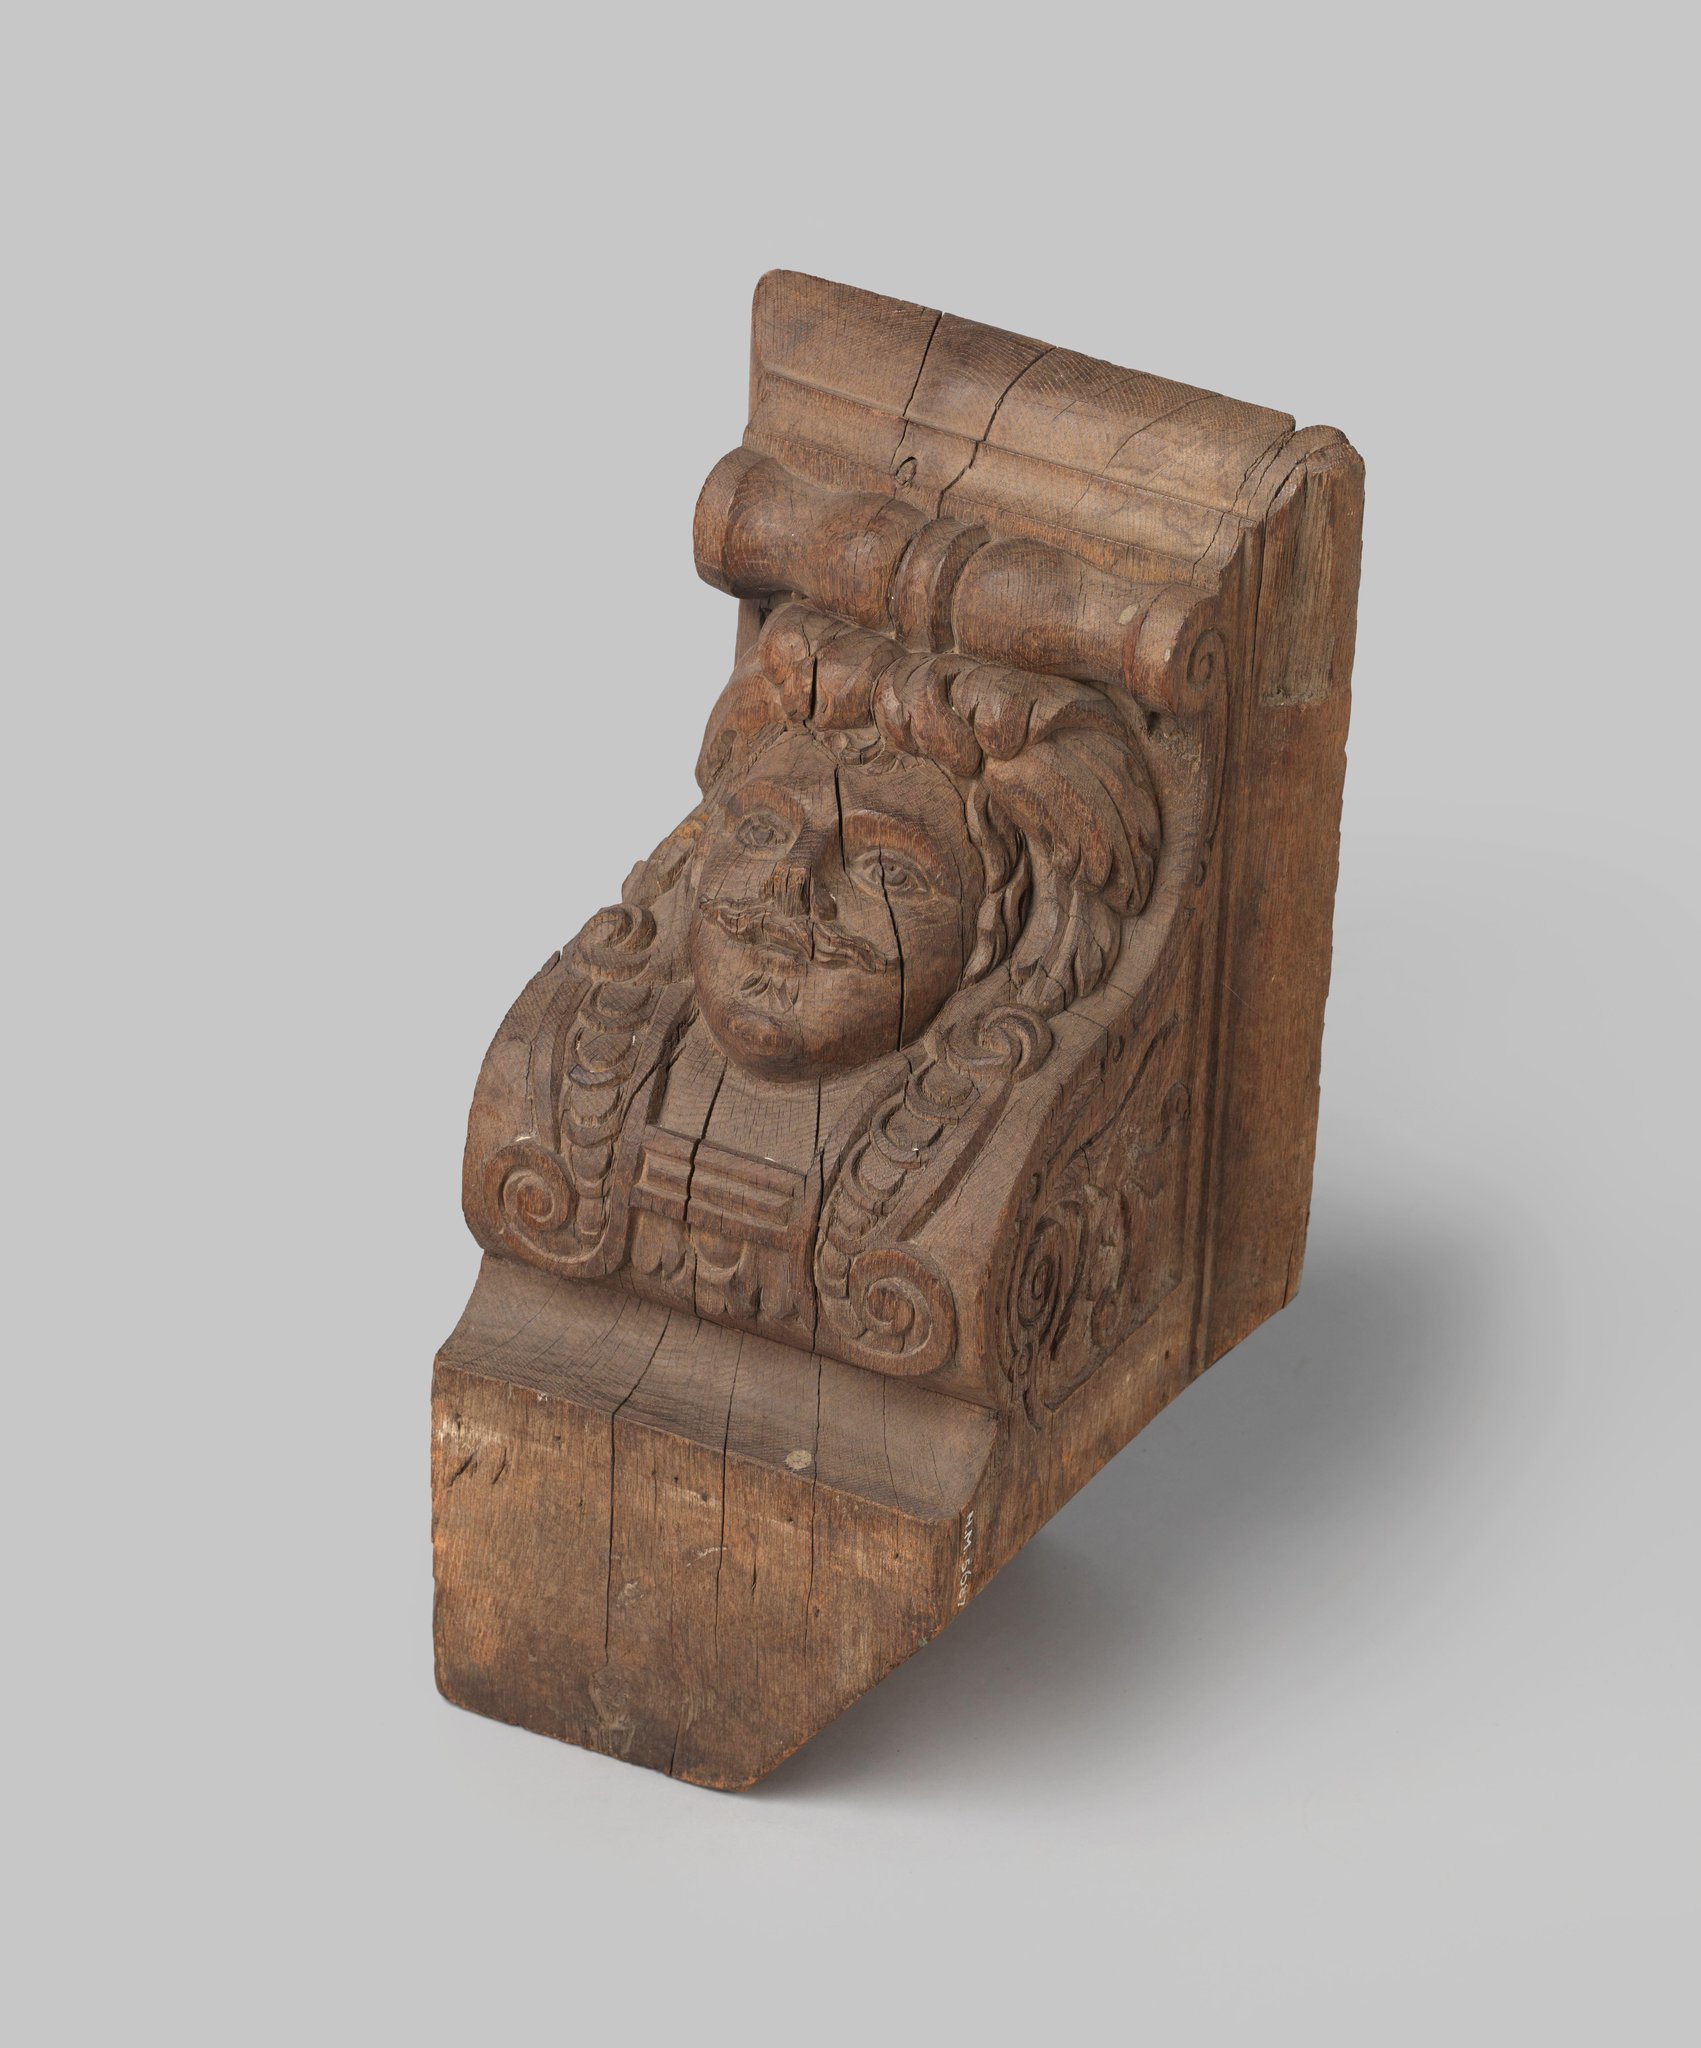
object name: console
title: Balkconsole van eikenhout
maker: Anonymous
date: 1600-1699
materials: wood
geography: northern netherlands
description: Eikenhouten balkconsole, die een gesneden mannekop vertoont, geplaatst onder een ornament gelijkend op een handvat en geflankeerd door twee voluten, gevuld met een guillochemotief.